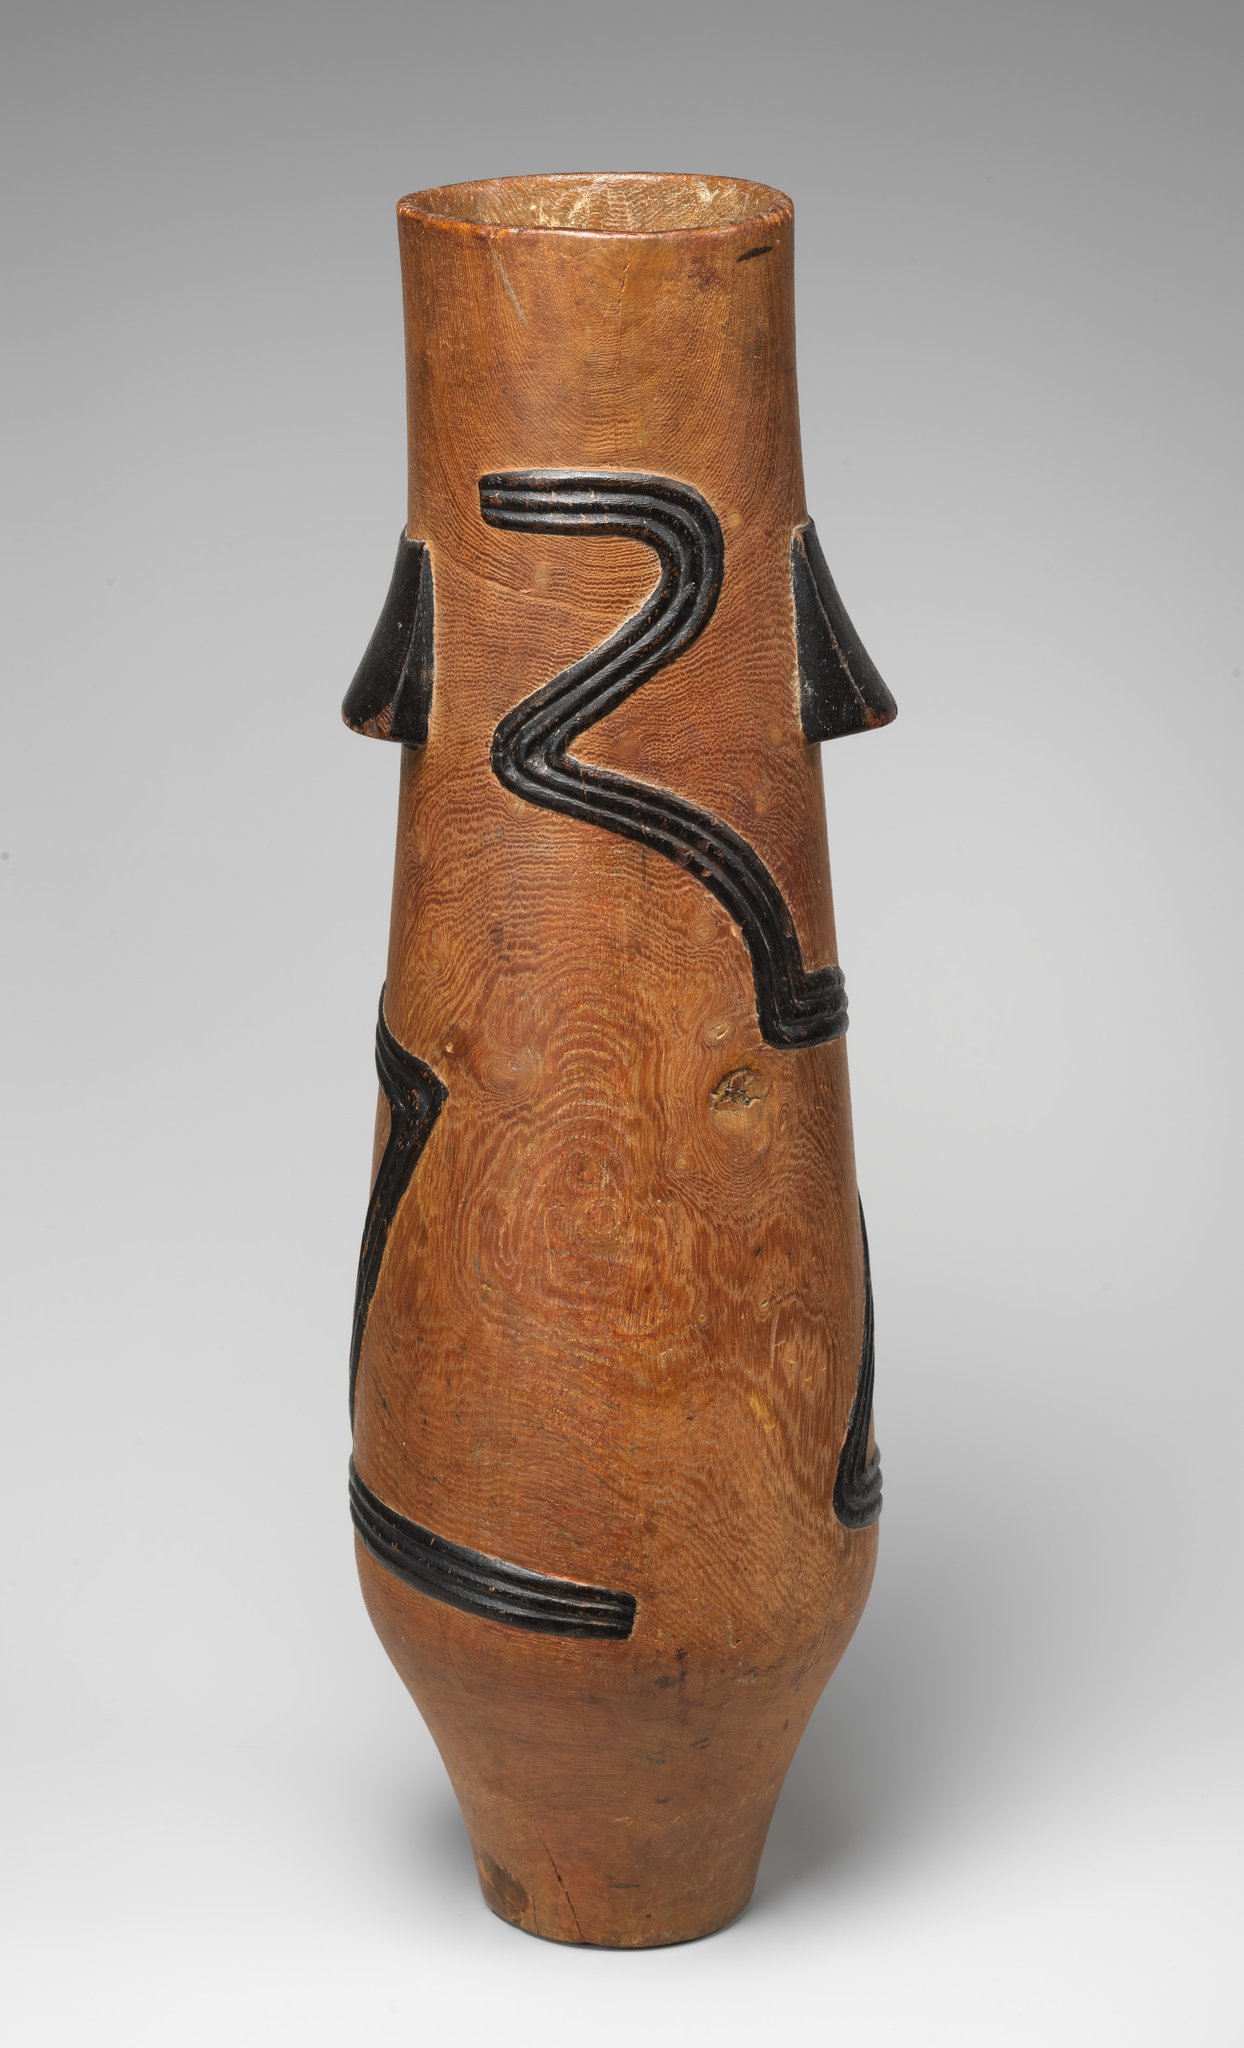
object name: vessel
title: Ithunga (milk vessel)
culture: zulu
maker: zulu artist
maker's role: artist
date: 1801-1900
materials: pigment, wood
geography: south africa